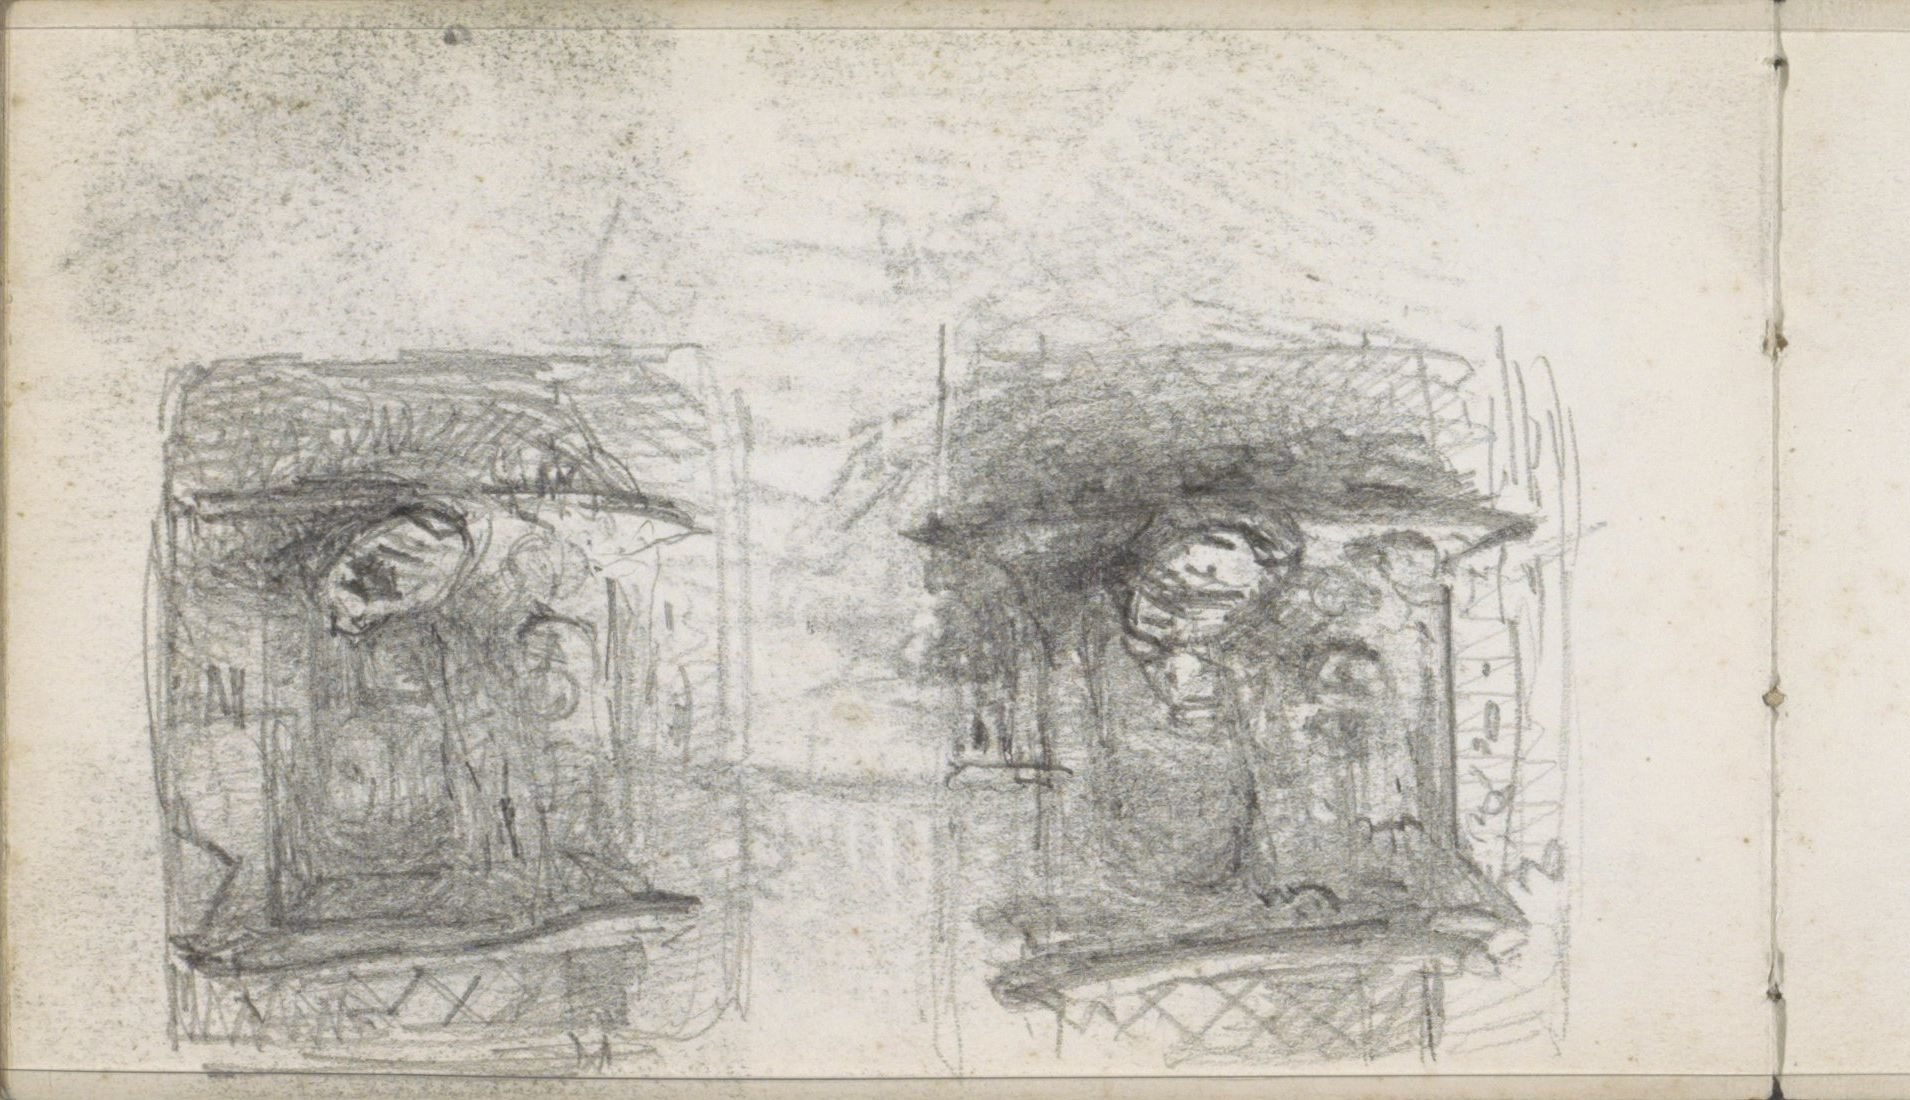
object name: sketchbook leaf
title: Stillevens op een schoorsteenmantel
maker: maria vos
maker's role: draughtsman, painter, print maker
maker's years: 1824-1906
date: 1863-1864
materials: paper, pencil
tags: chimney-piece, mantelpiece, still life of miscellaneous objects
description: Blad 40 verso uit een schetsboek met 41 bladen.